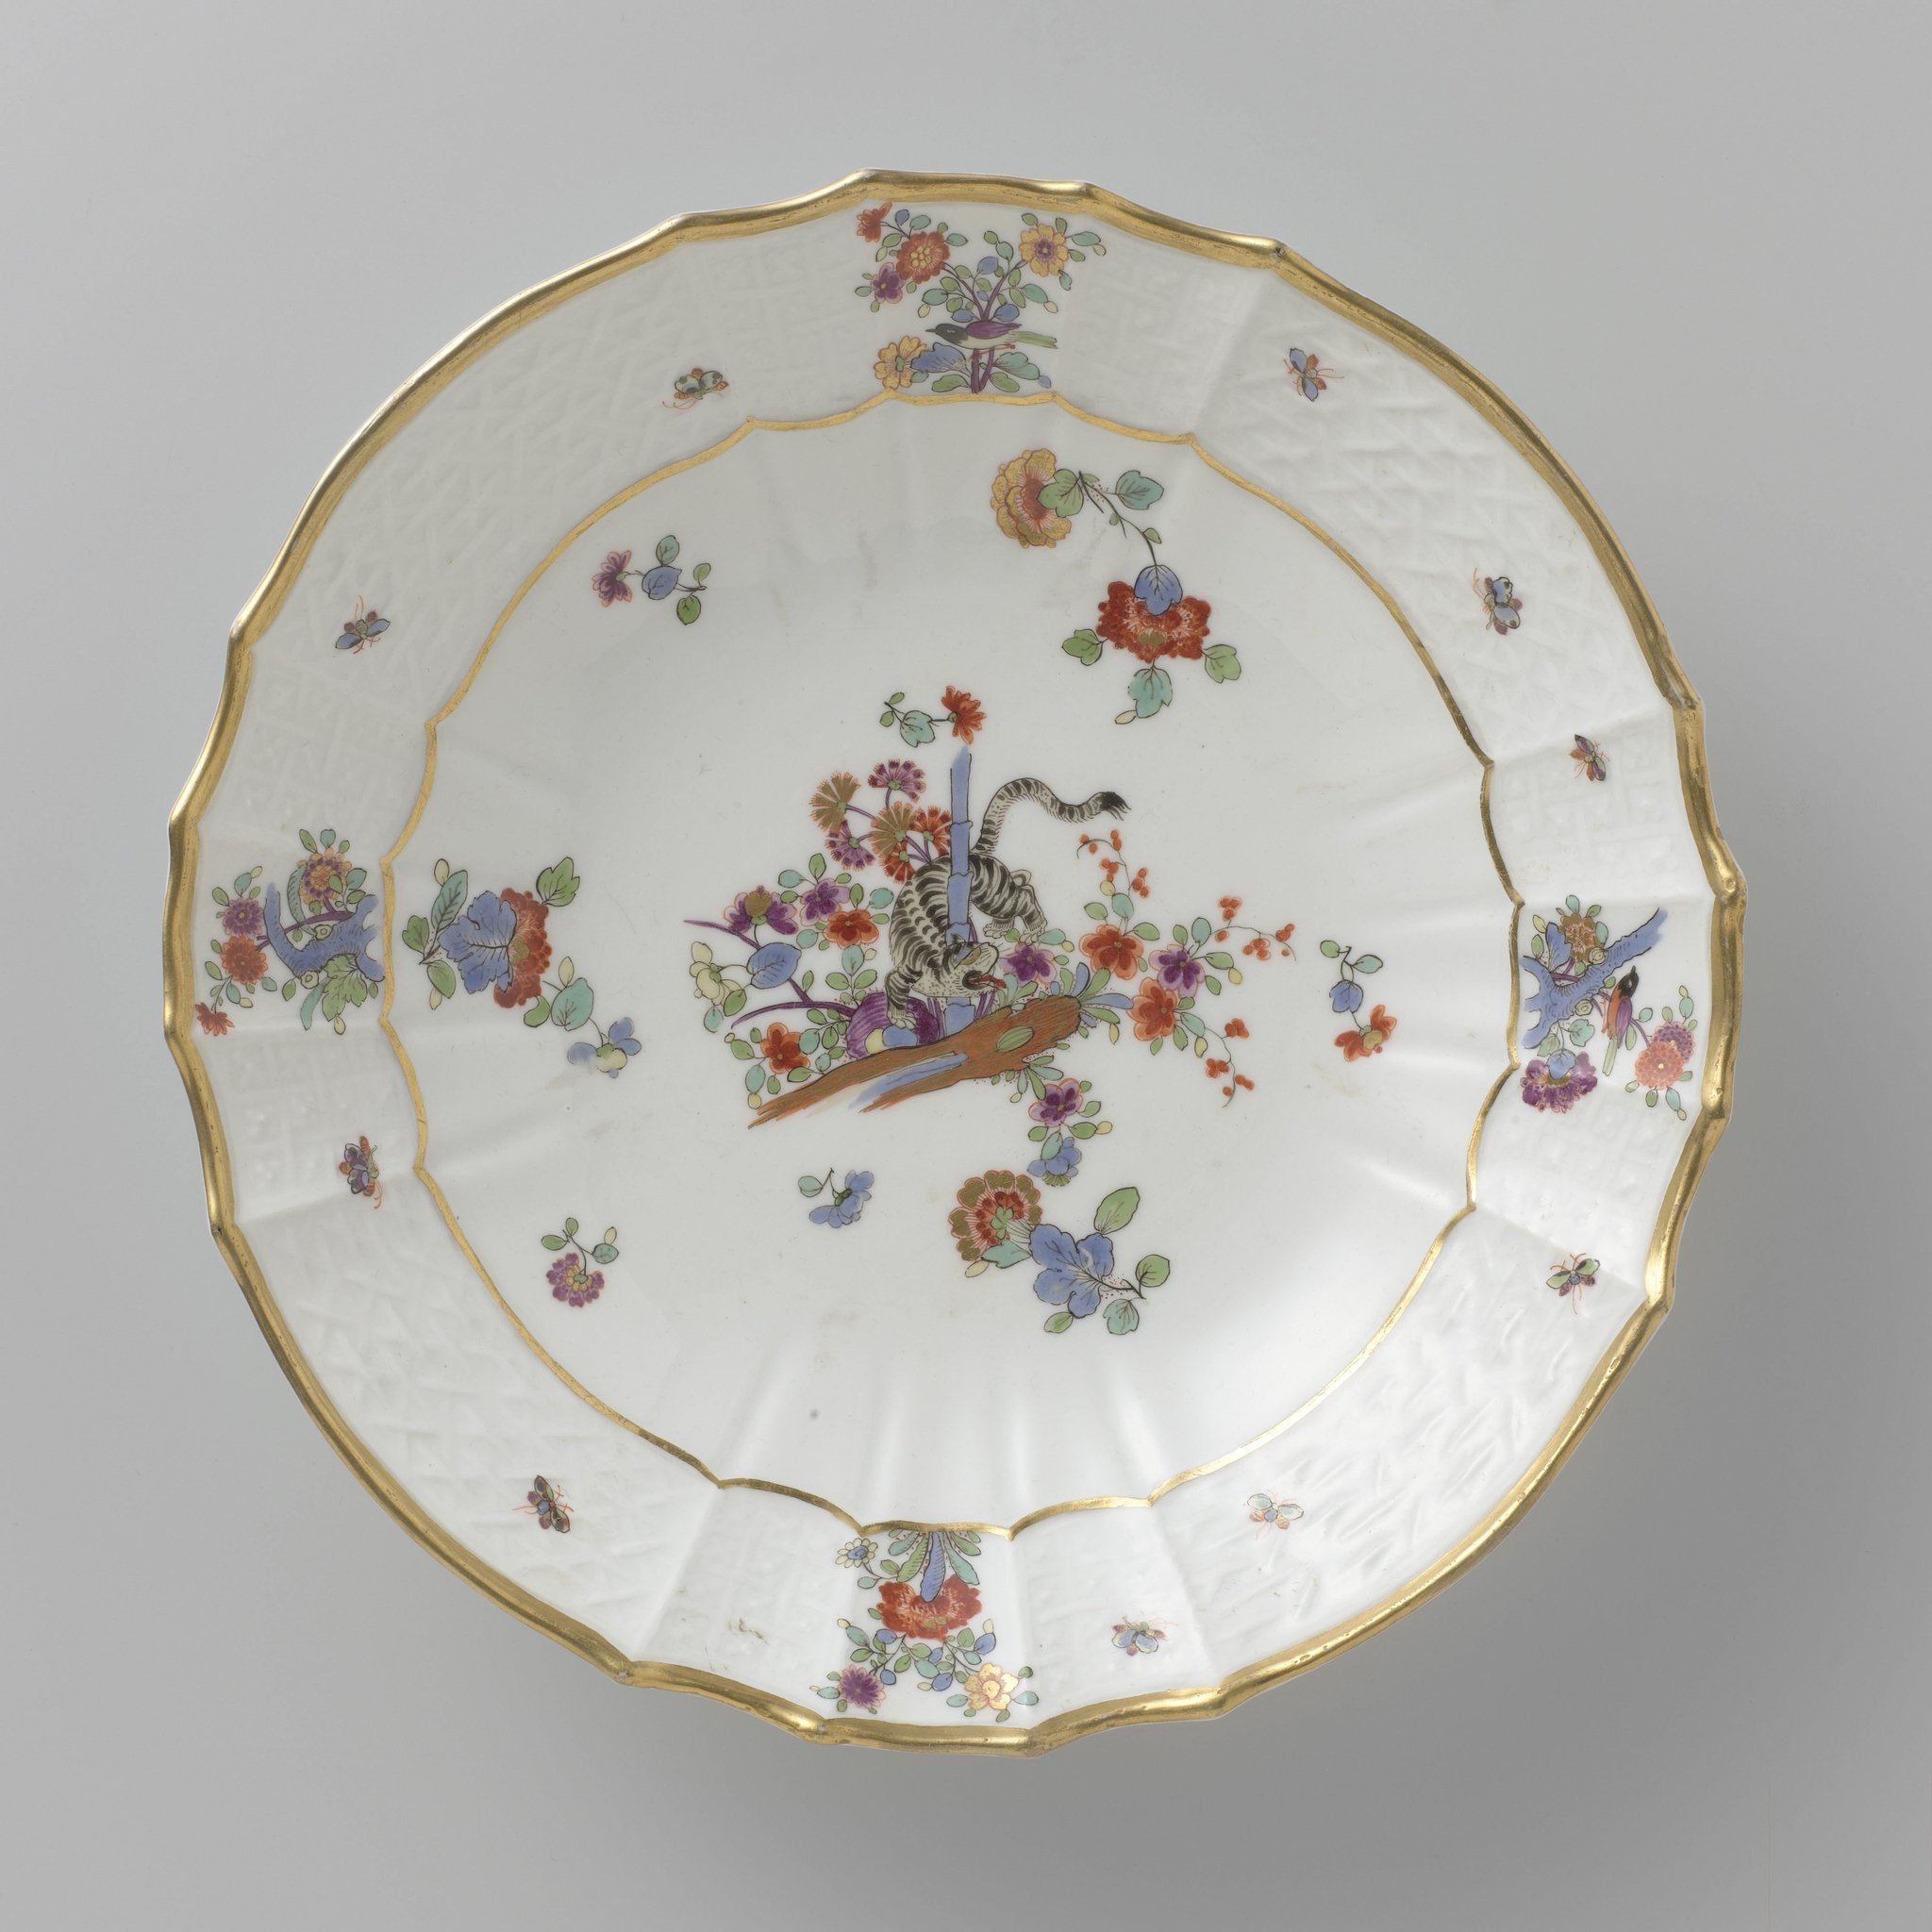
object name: platter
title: Schotel, veelkleurig beschilderd met een Kakiemon-decor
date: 1740-1745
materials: porcelain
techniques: painted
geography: meissen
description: Ronde schotel van beschilderd porselein. De schotel heeft een geribde en geschulpte rand. De schotel is beschilderd met een tijger om een bamboestengel, gestrooide Indianische Blumen, vlinders en takken met vogels. De rand is versierd met het 'Altbrandenstein'-patroon. De schotel is gemerkt.